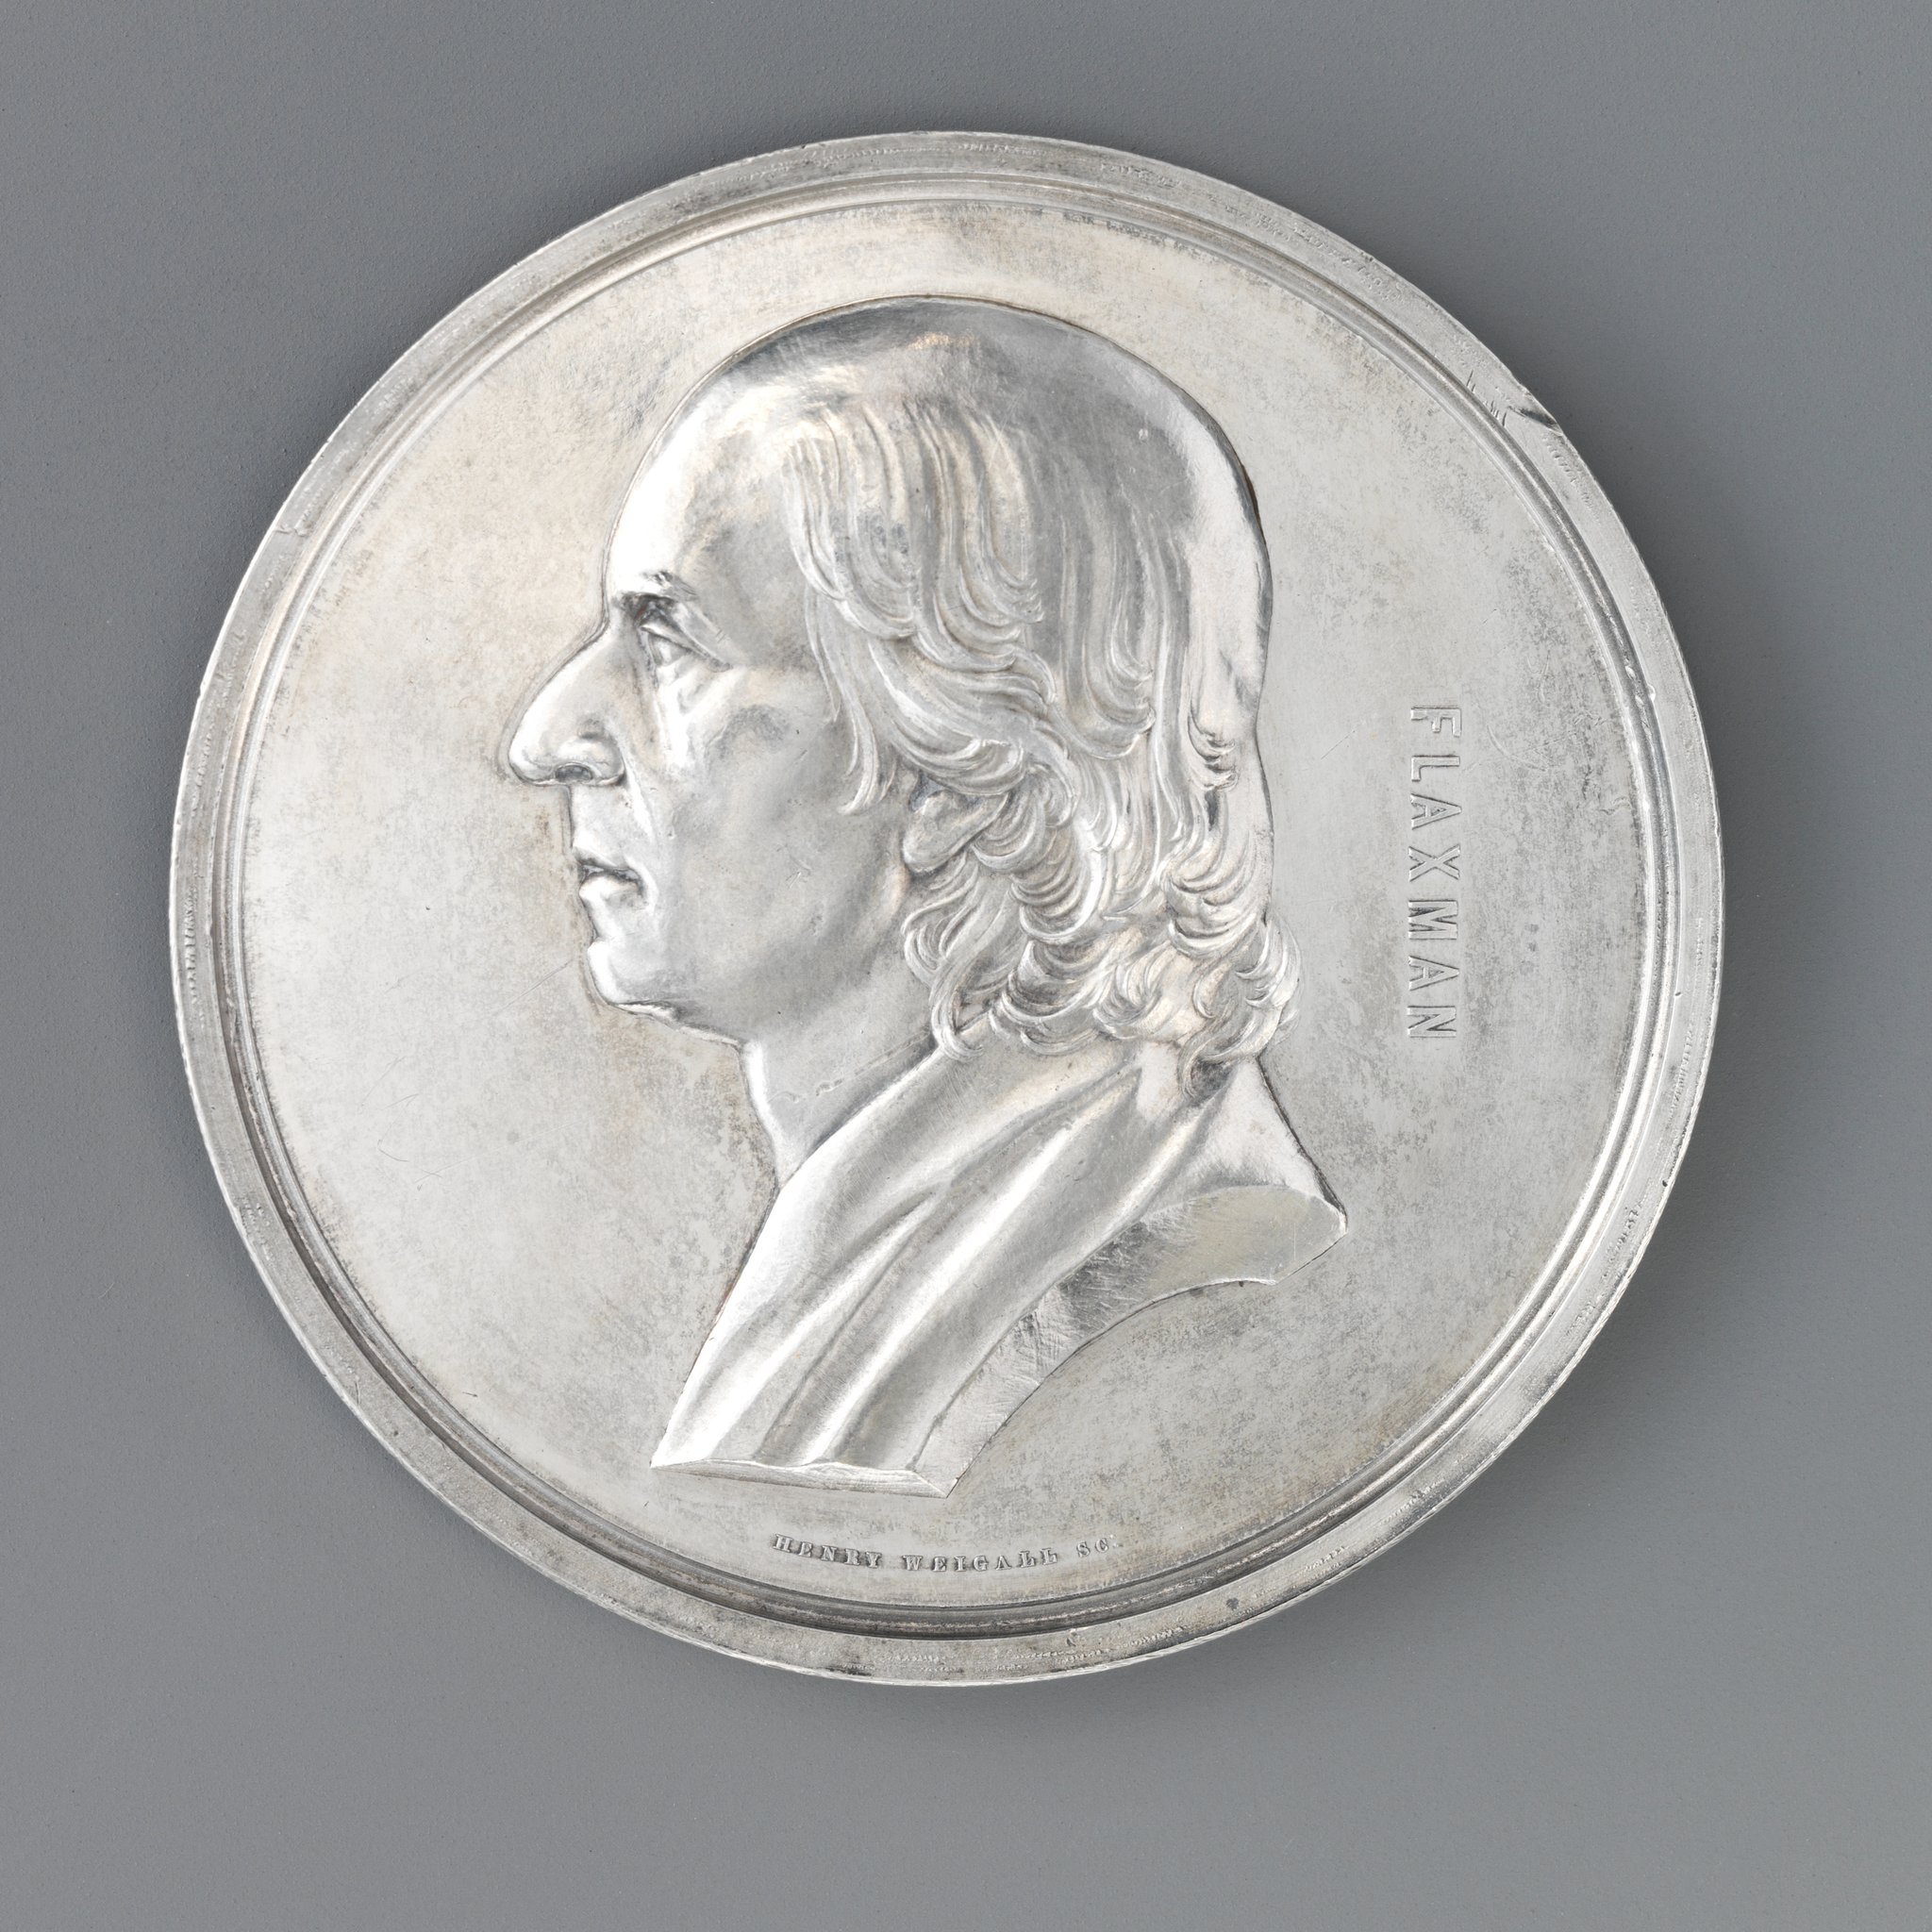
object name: medal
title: John Flaxman (1755–1826)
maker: henry weigall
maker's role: artist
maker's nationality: british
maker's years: 1800-1883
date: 1854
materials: silver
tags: men,profiles